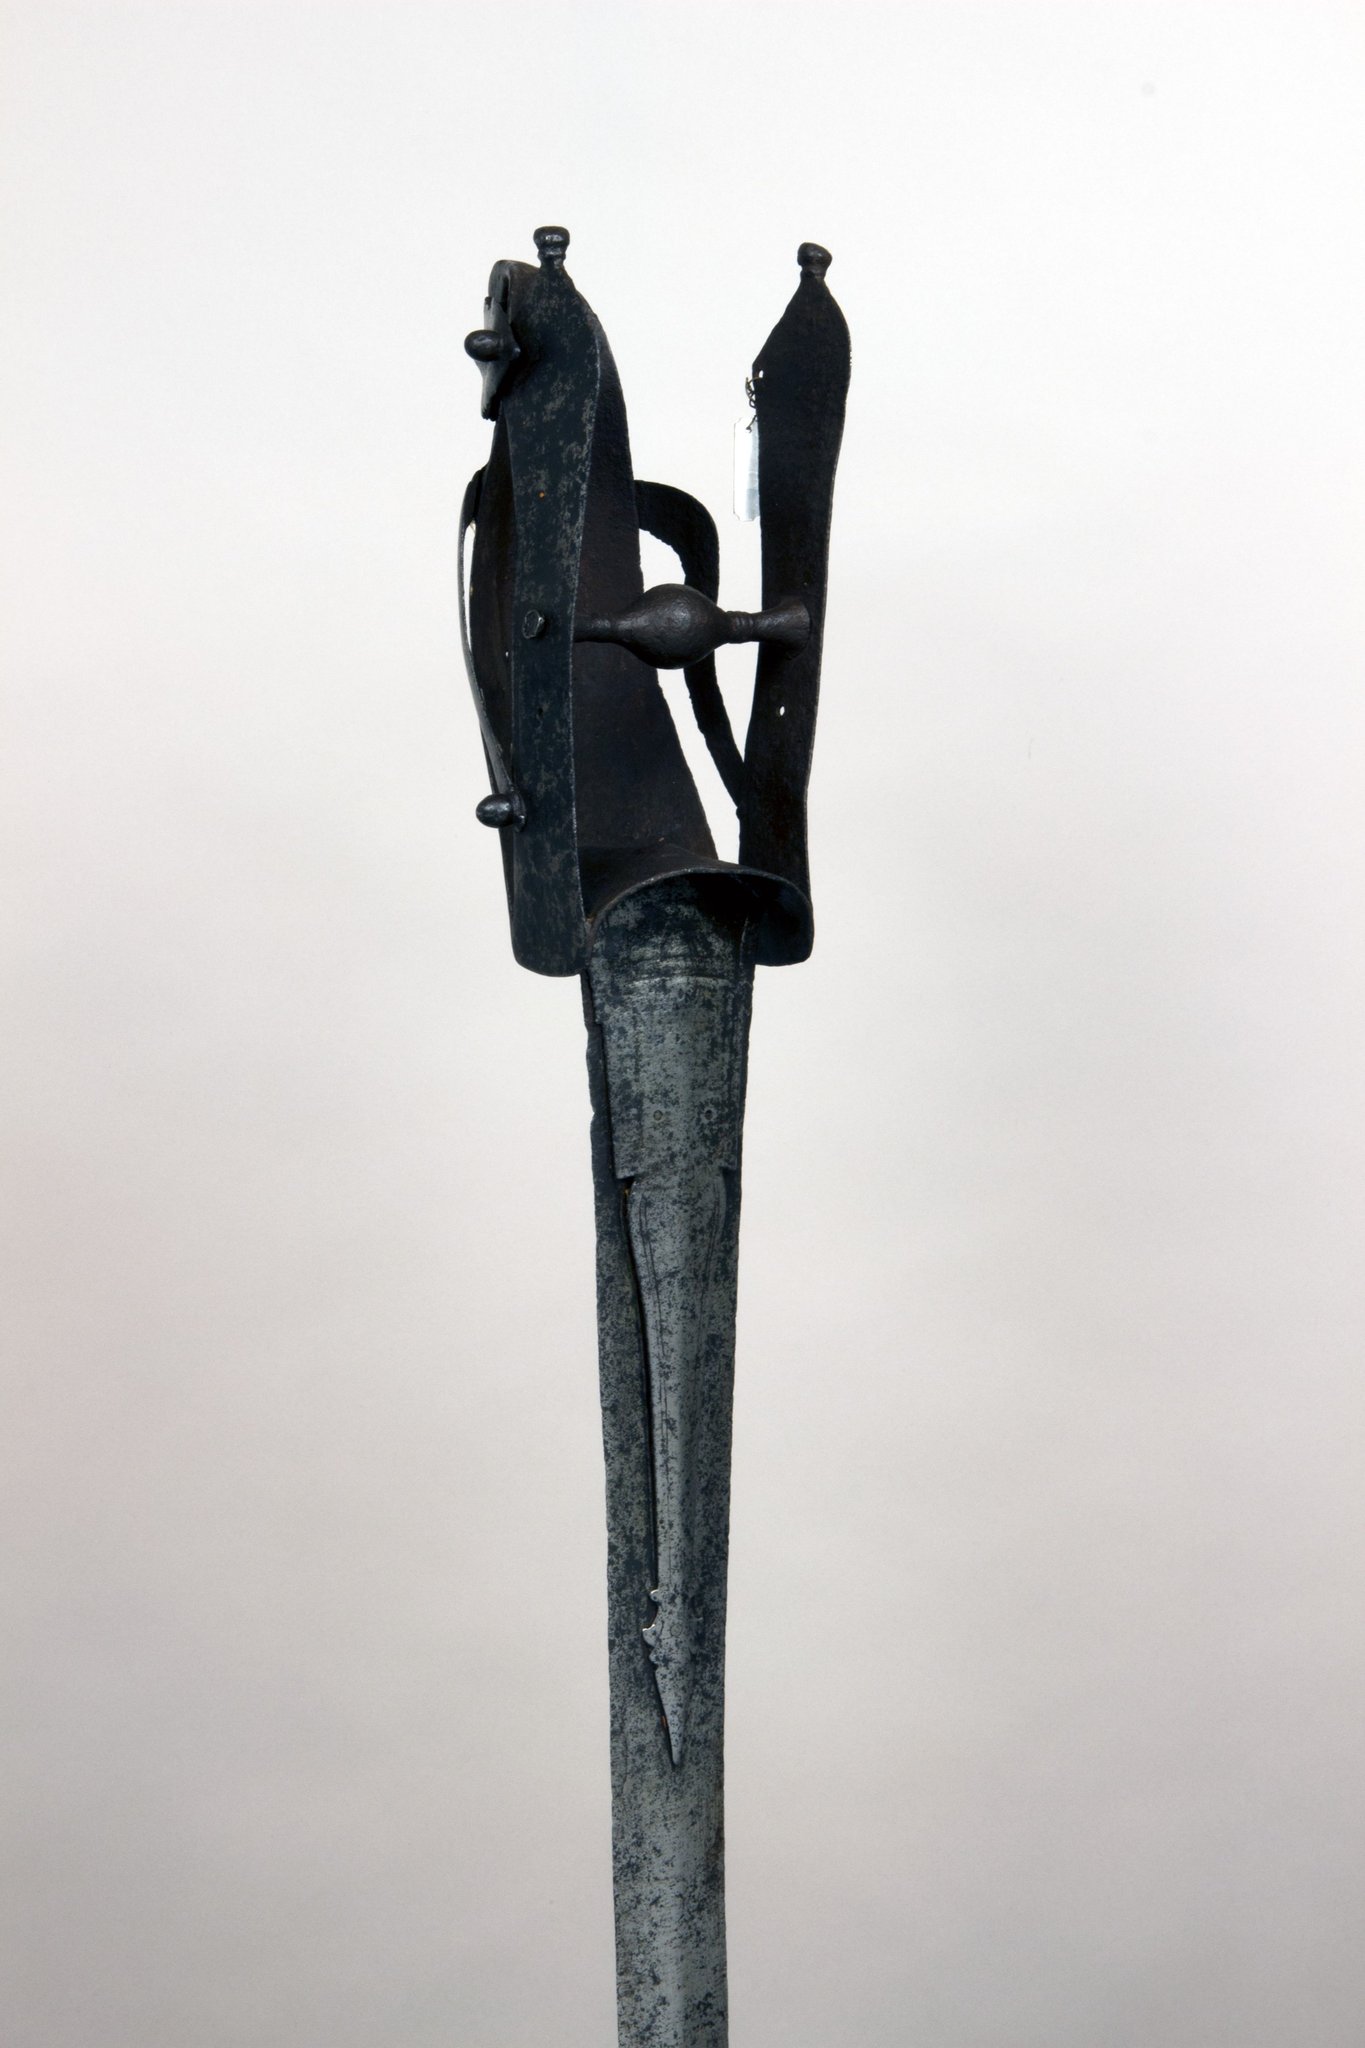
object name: dagger katar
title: Dagger (Katar)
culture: indian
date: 1601-1700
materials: steel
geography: south india